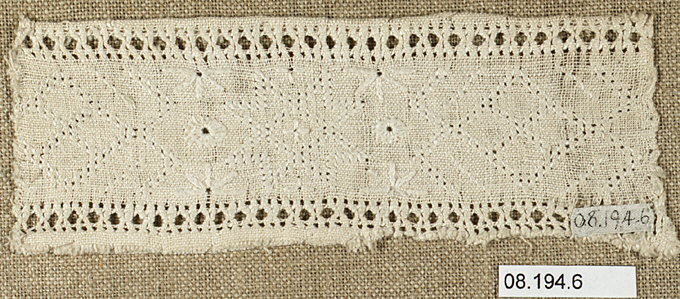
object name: fragment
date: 1601-1700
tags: flowers,leaves